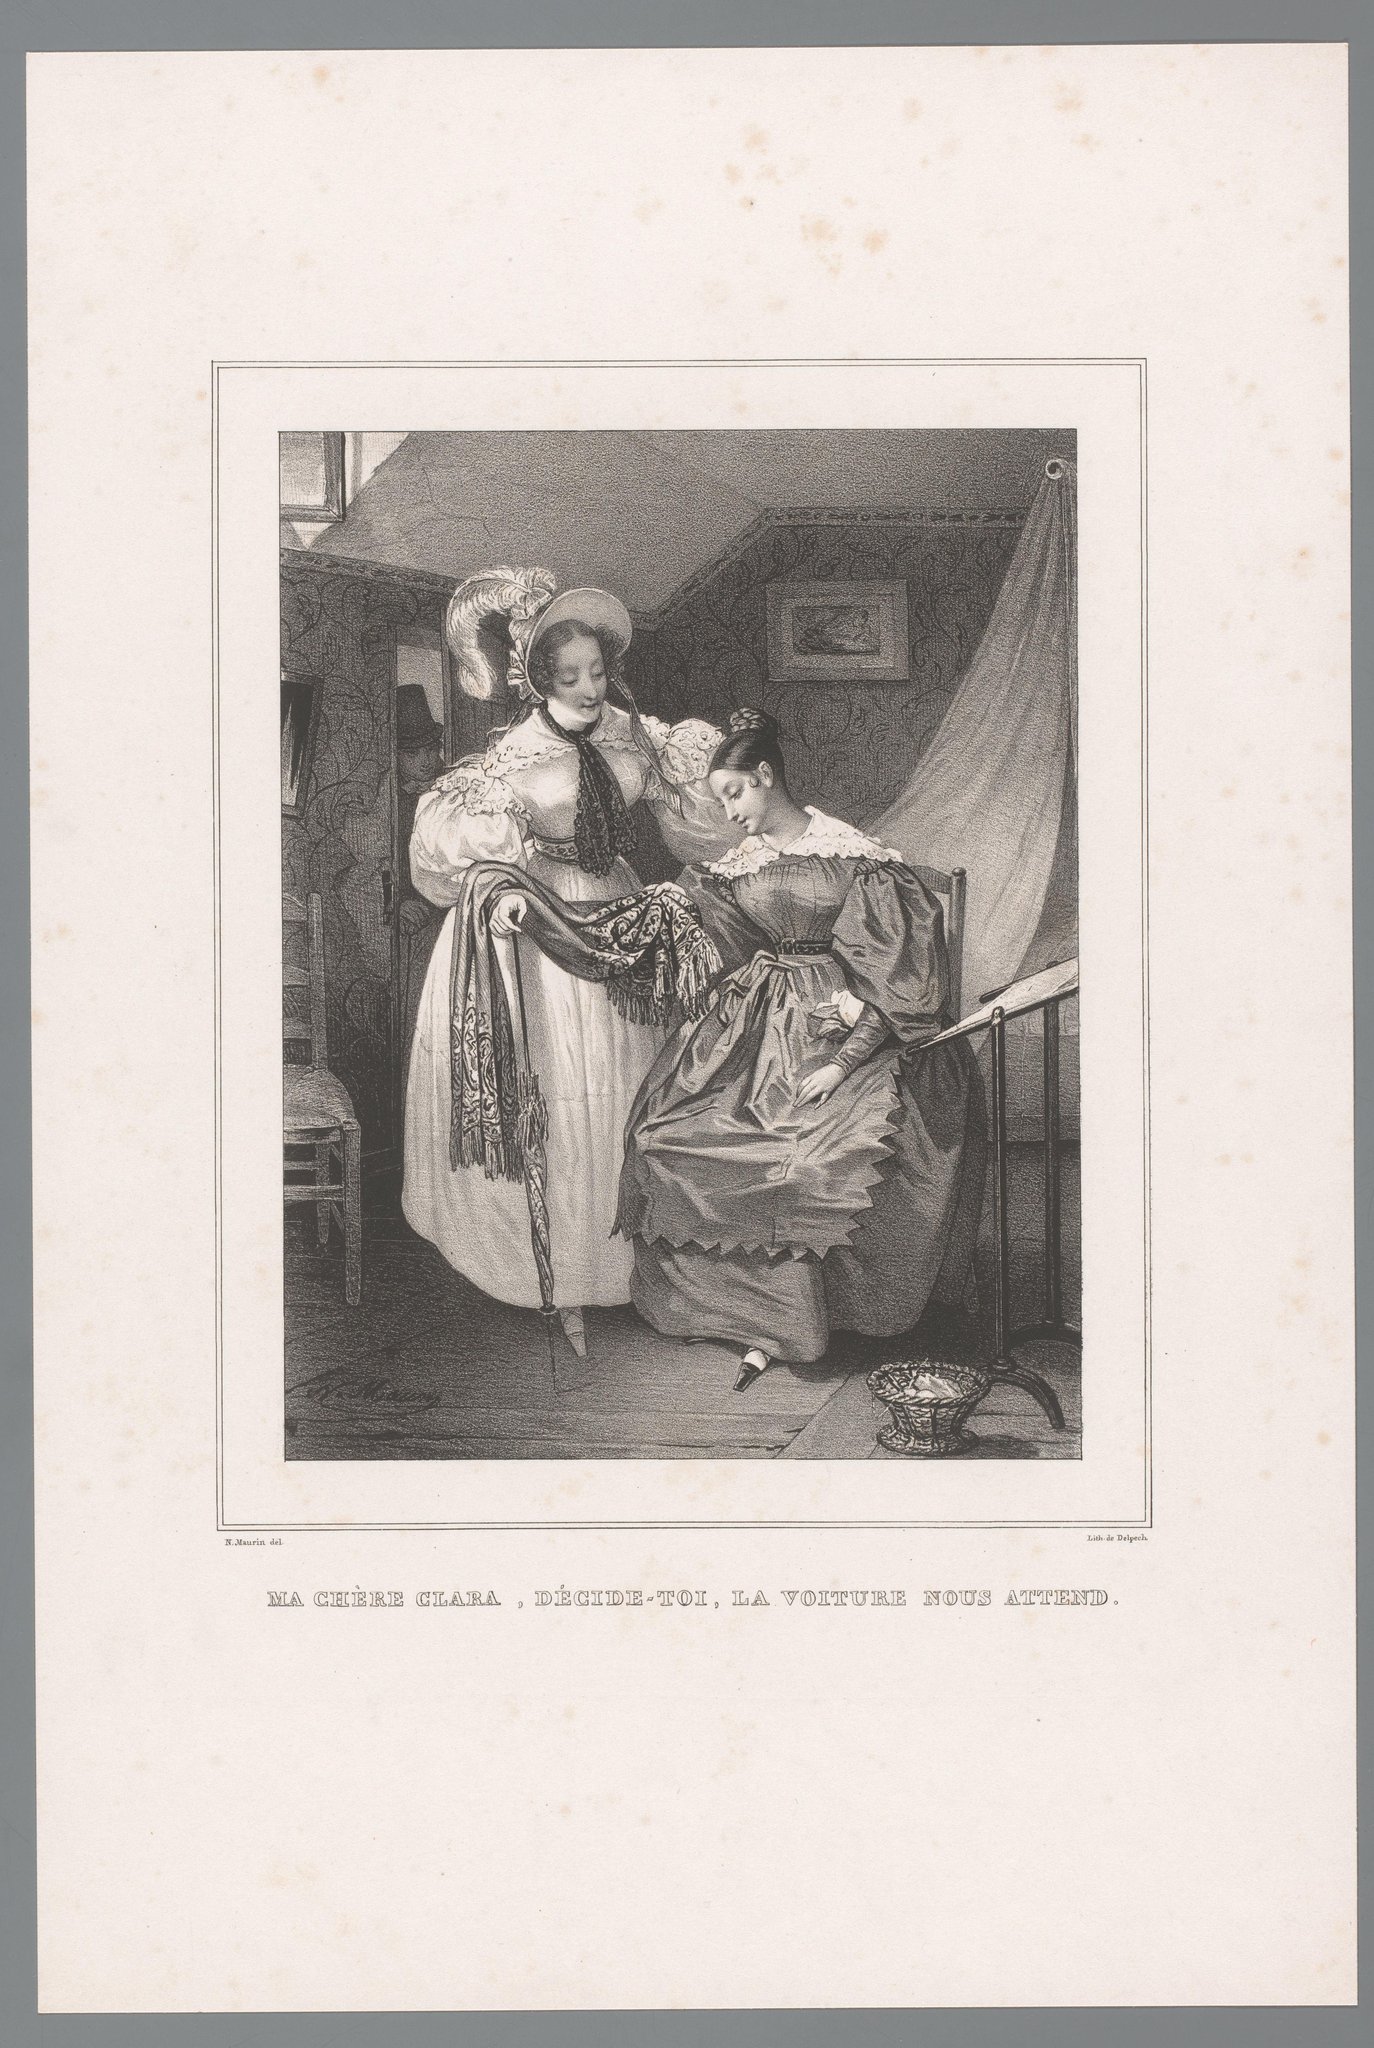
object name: print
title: Clara trompée ou les liaisons dangereuses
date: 1825-1842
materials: paper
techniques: lithograph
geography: paris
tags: fashion, clothing, intrigue, specific works of literature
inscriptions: collector's mark: Lugt 2760, collector's mark: Lugt 2228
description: Het verhaal is gebaseerd op het boek 'Les liaisons dangereuses' van Pierre Choderlos de Laclos.